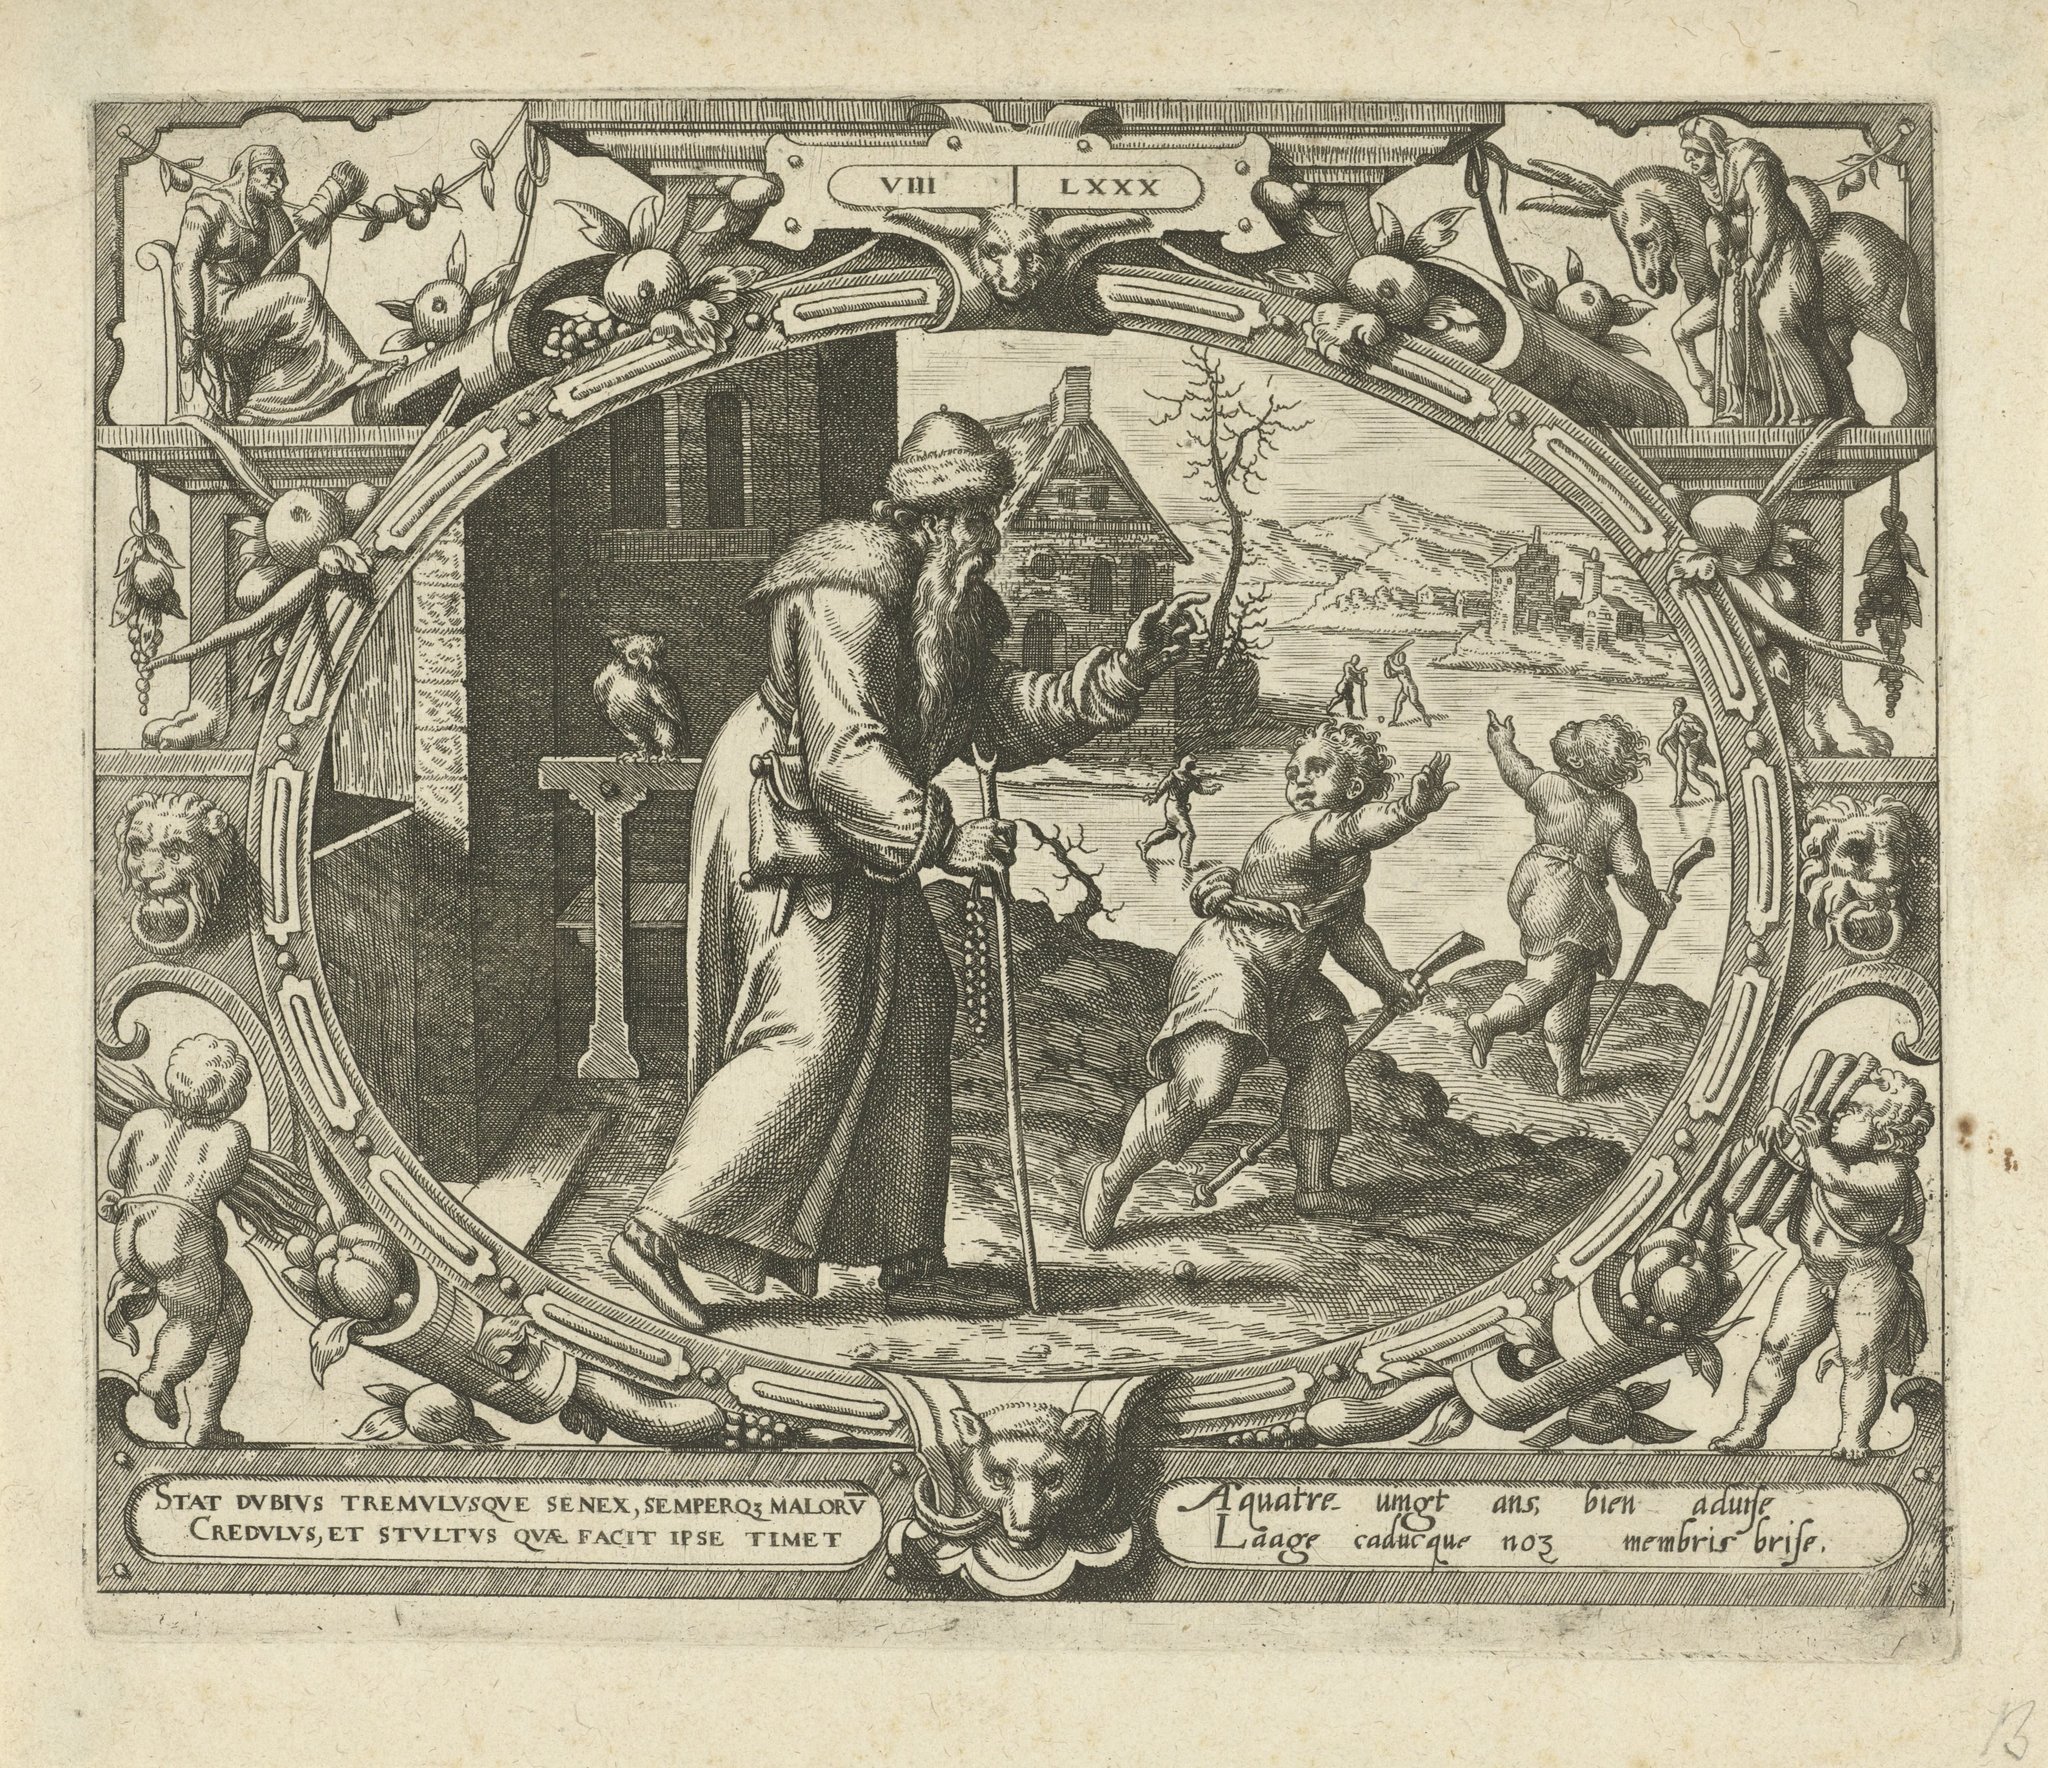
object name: print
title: De mens op tachtigjarige leeftijd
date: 1569-1575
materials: paper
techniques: engraving, etching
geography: antwerp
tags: walking-stick, staff, old man, owls, 'kolf' on the ice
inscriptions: collector's mark: Lugt 2228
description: In een ovaal kader versierd met ornamenten een voorstelling van een oude man die twee jongeren vermanend toespreekt. In zijn hand een stok en een rozenkrans. De twee jongeren hebben kolven vast en rennen richting een bevroren rivier. Links op de achtergrond een uil. De prent heeft een Latijns en Frans onderschrift.